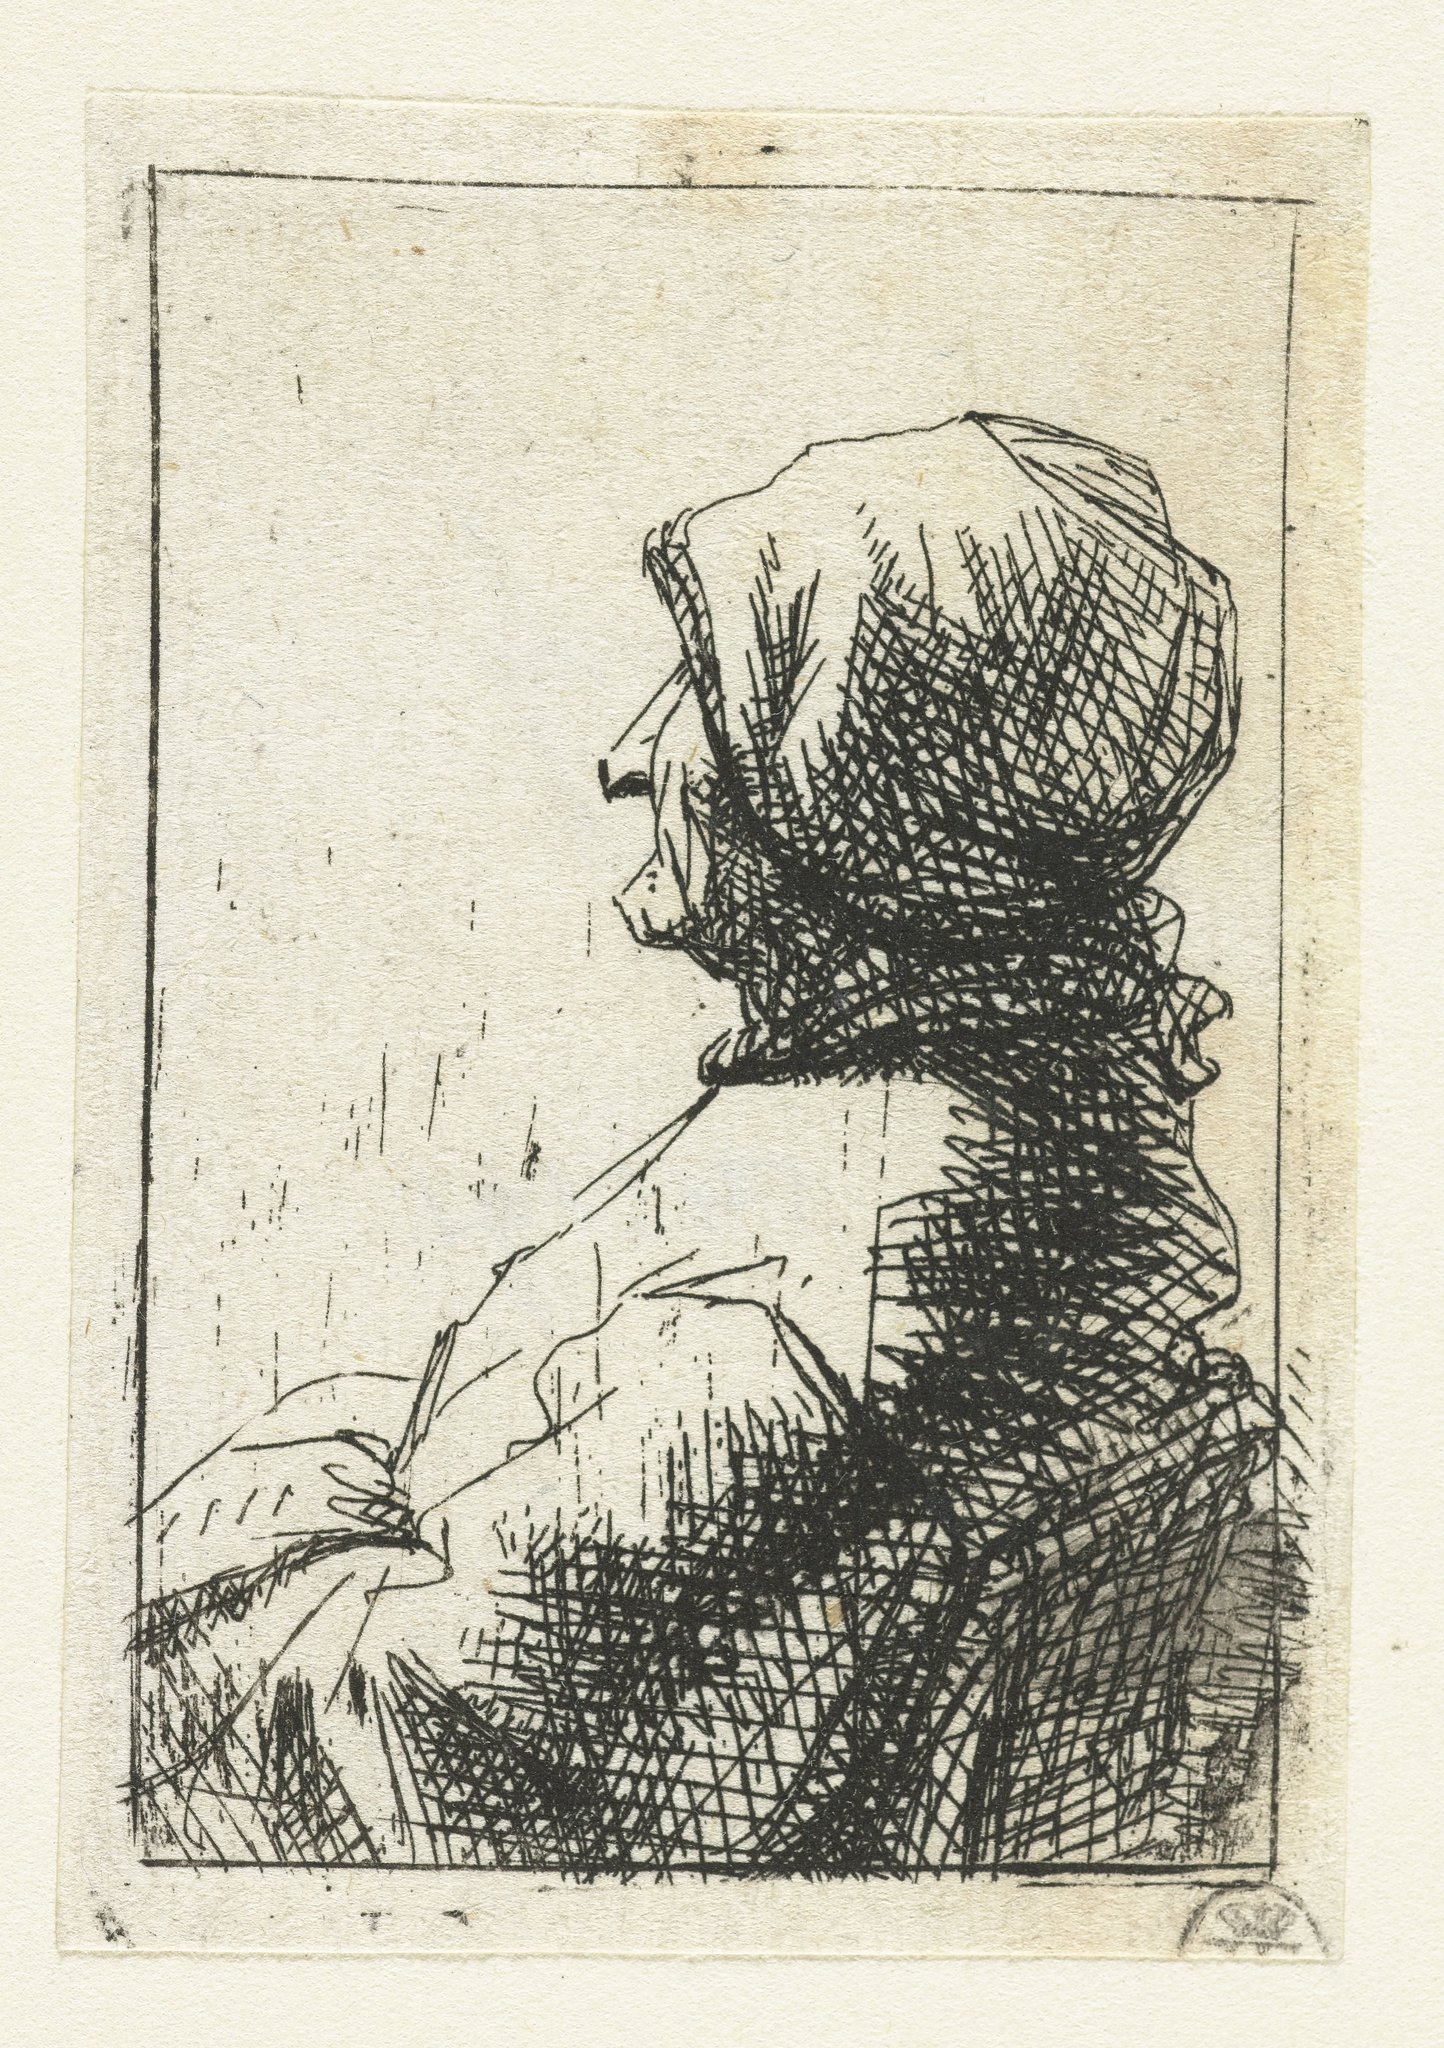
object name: print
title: Zittende oude vrouw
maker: michael willmann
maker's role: draughtsman, print maker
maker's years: 1630-1706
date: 1640-1706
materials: paper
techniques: etching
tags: old woman (+ sideview, profile)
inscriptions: collector's mark: Lugt 971